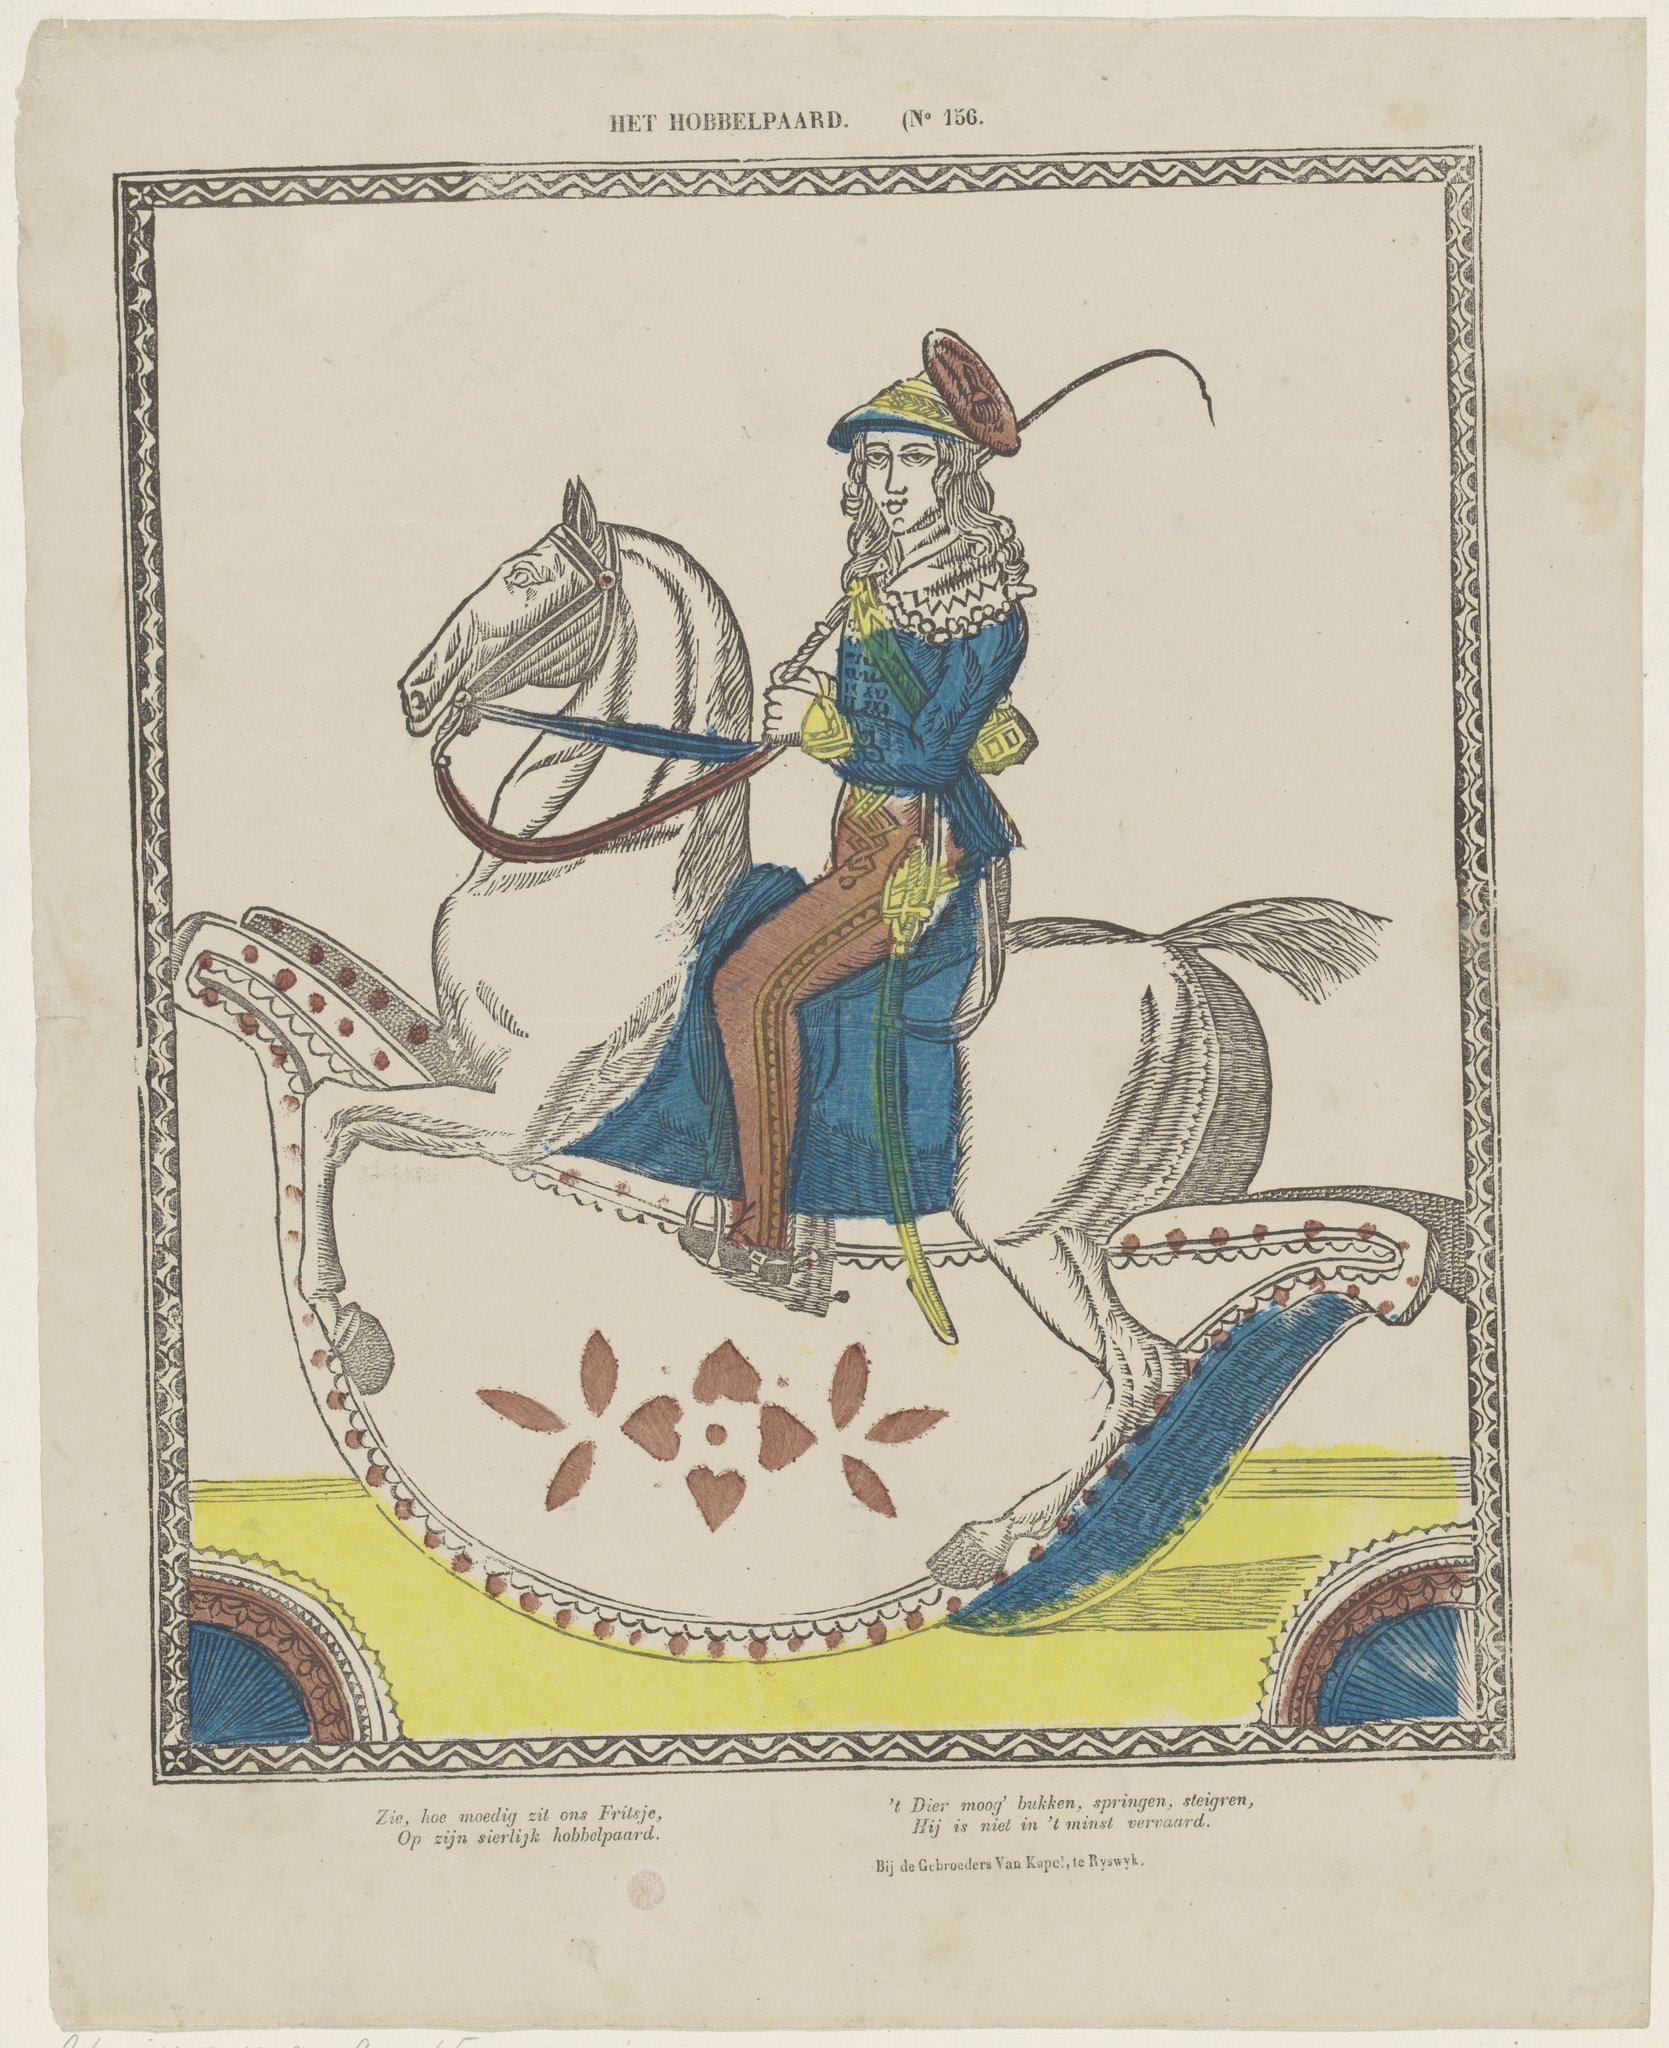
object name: popular print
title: Het hobbelpaard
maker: Anonymous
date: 1833-1856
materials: paper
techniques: colour, letterpress printing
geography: turnhout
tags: rocking-horse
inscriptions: collector's mark: Lugt 2760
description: Blad met een grote voorstelling van een jongen op een hobbelpaard. Geheel omgeven door een sierrand. In de ondermarge een vierregelig vers in twee kolommen. Genummerd midden boven: (No 156.